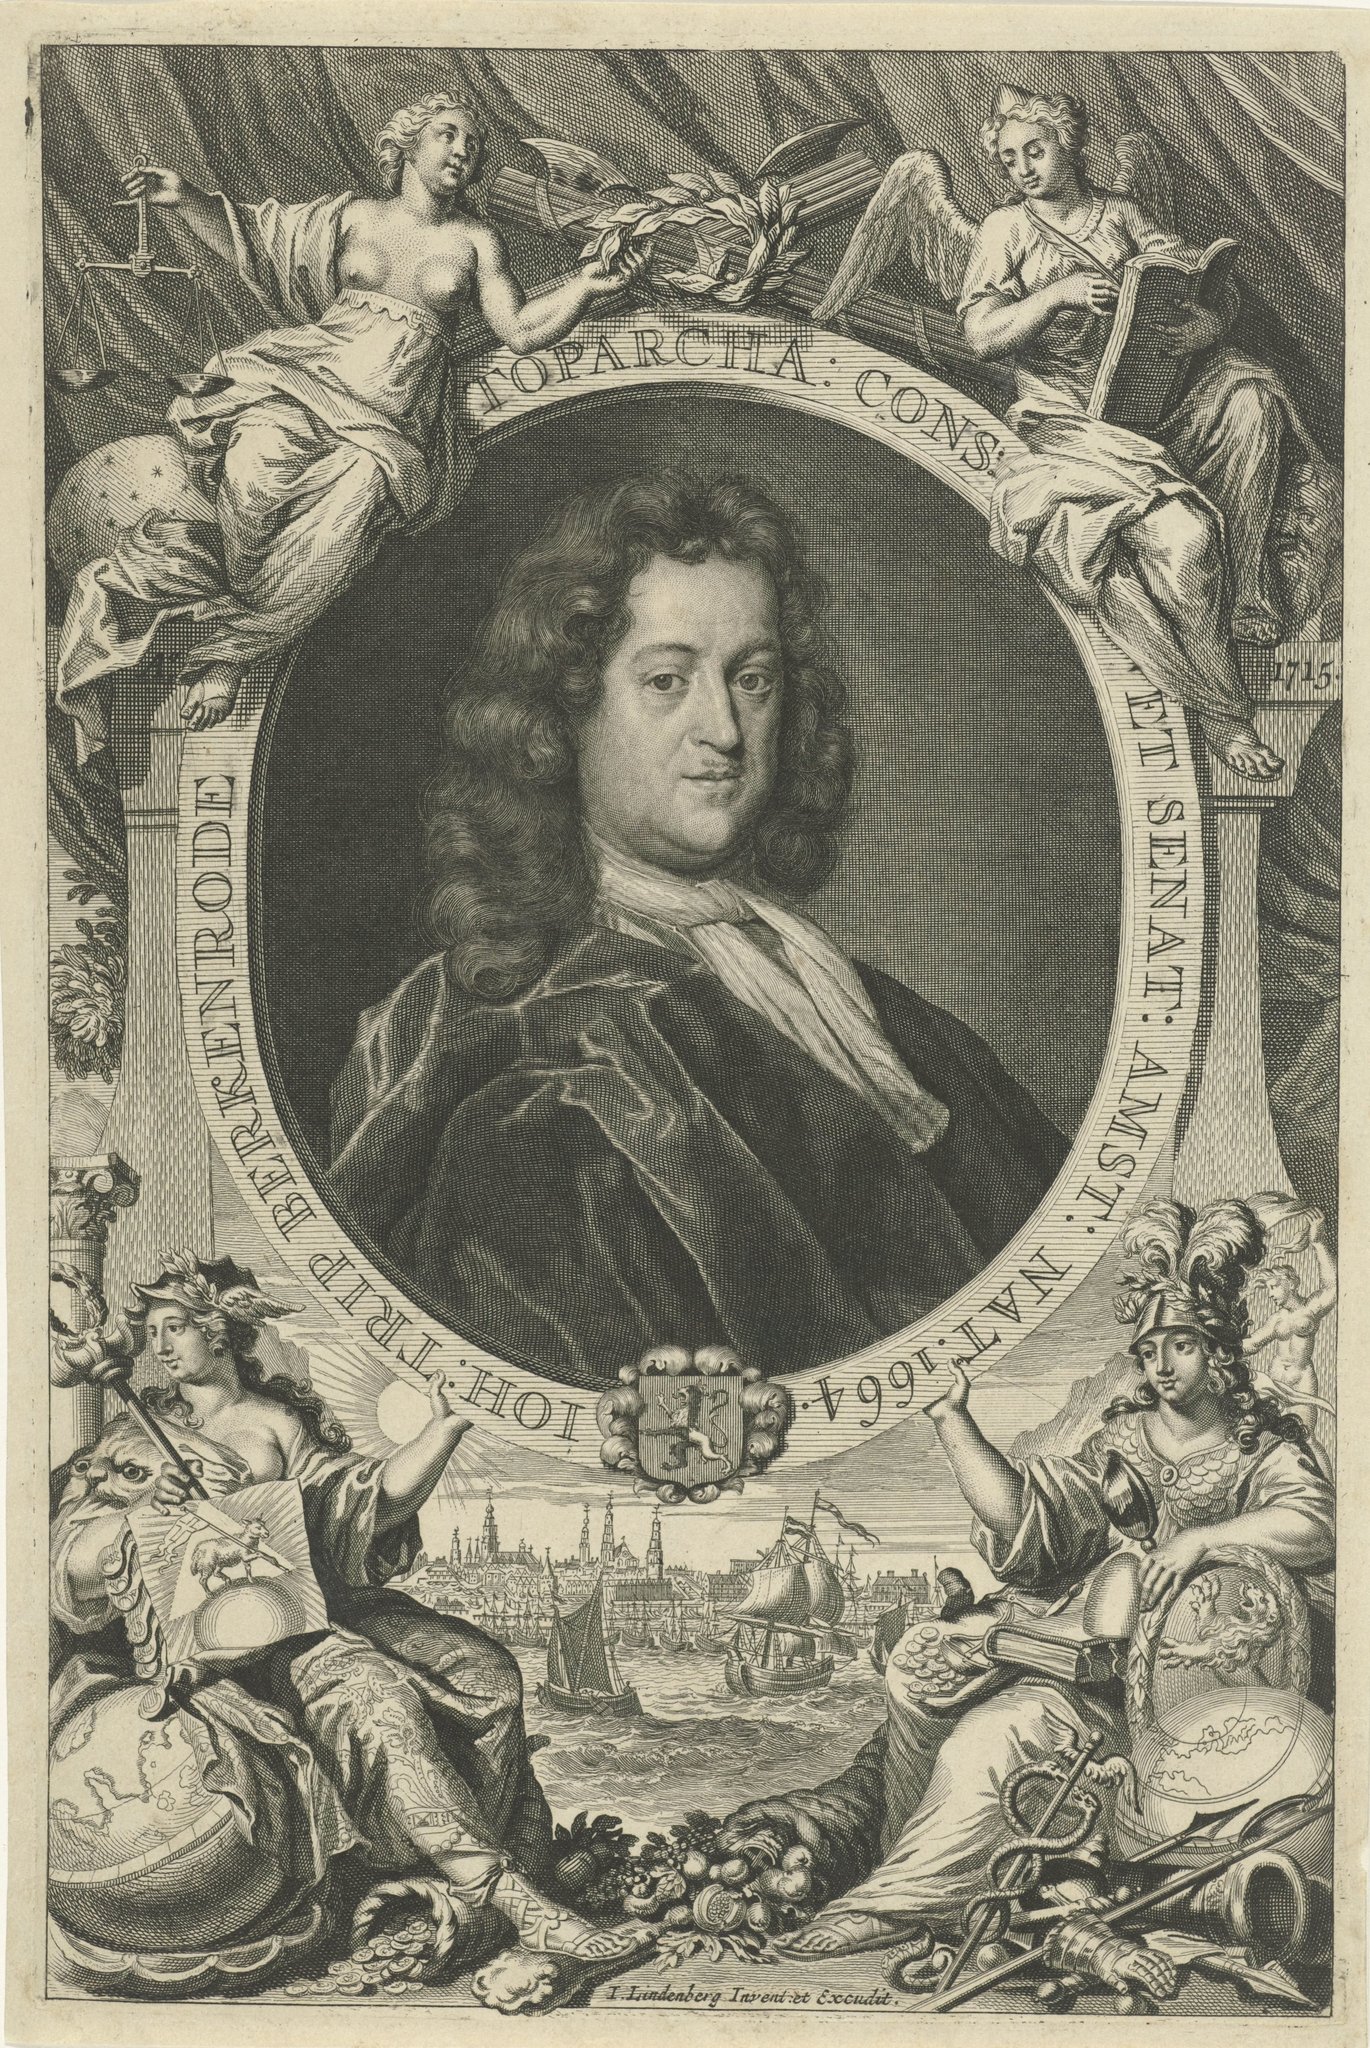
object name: print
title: Portret van Jan Trip Berkenrode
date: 1715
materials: paper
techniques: engraving, etching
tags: justice, 'justitia'; 'giustitia divina' (ripa) ~ one of the four cardinal virtues, truth; 'verità' (ripa), welfare, prosperity; 'felicità publica', 'prosperità della vita', 'salute' (ripa), allegory of trade; 'commertio della vita humana' (ripa), amsterdam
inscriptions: collector's mark: Lugt 2228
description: Jan Trip Berkenrode, burgemeester van Amsterdam. Boven het portret de personificaties Rechtvaardigheid en Waarheid. Onder het portret een gezicht op Amsterdam tussen de personificaties van Handel en Welvaart.